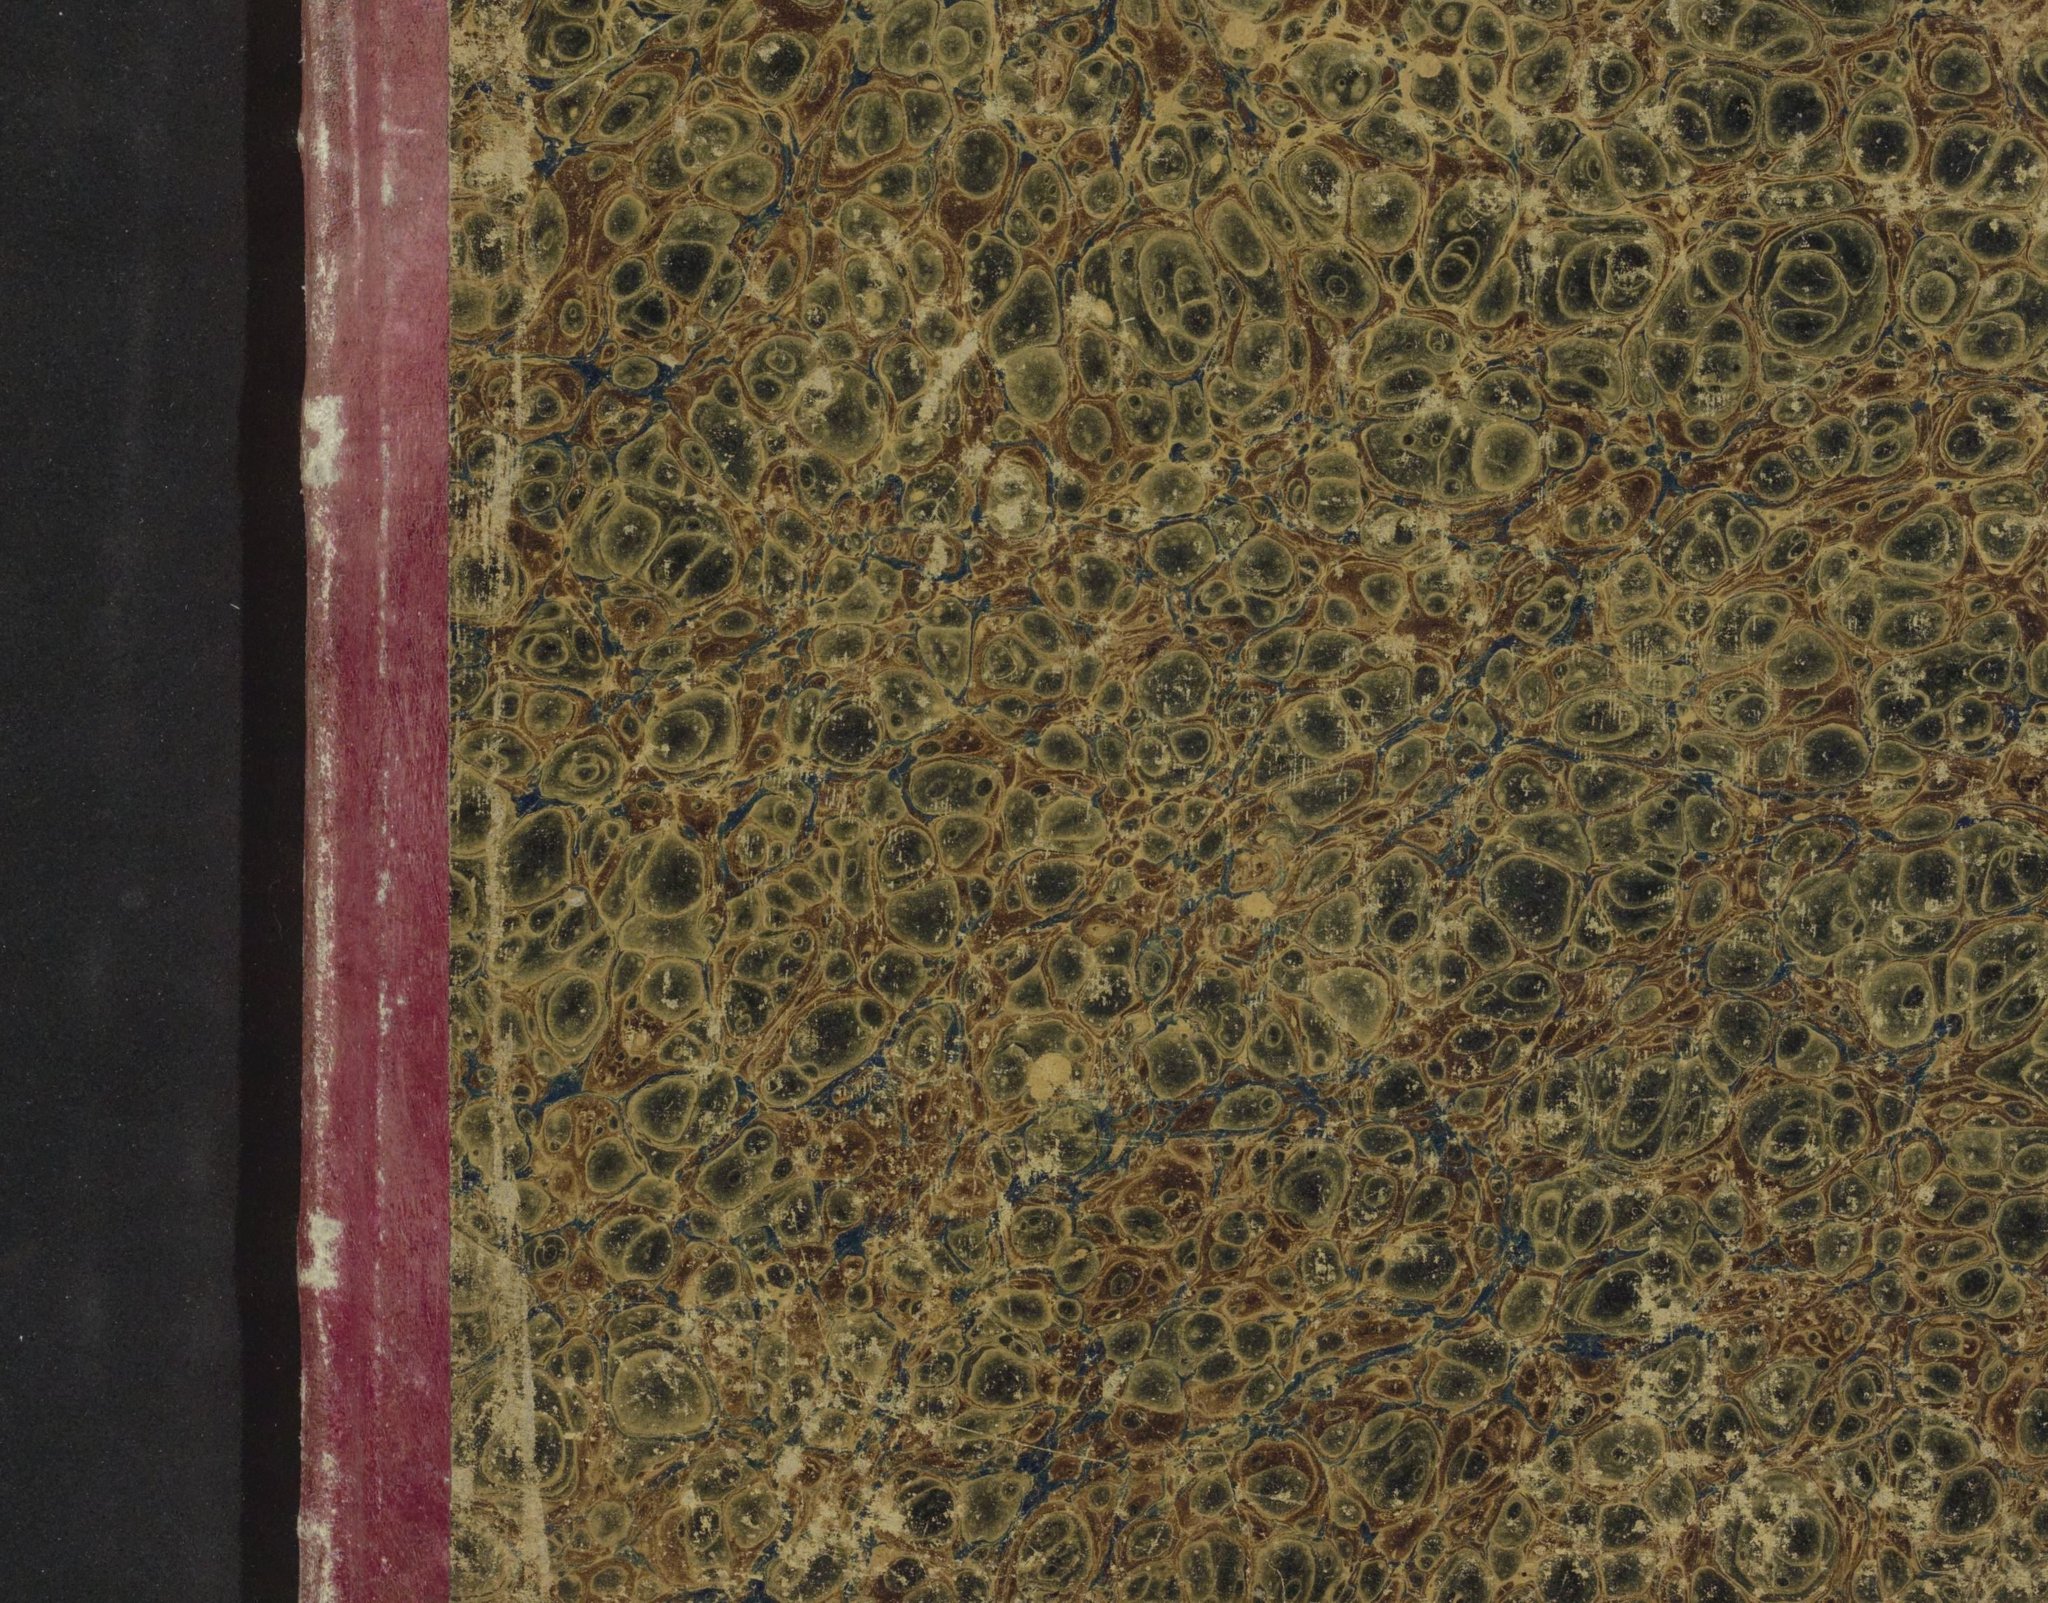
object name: sketchbook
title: Schetsboek met 28 pagina's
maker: willem springer jr.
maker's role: draughtsman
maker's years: 1815-1907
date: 1825-1907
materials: cardboard, ink, paper, pencil, watercolor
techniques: brush, pen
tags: plan ~ architecture, exterior ~ architectural design or model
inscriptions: collector's mark: Lugt 2228a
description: Schetsboek bestaande uit 28 pagina's met met architectuurstudies, onder andere plattegronden en opstanden van de gevels van stadshuizen en villa's.